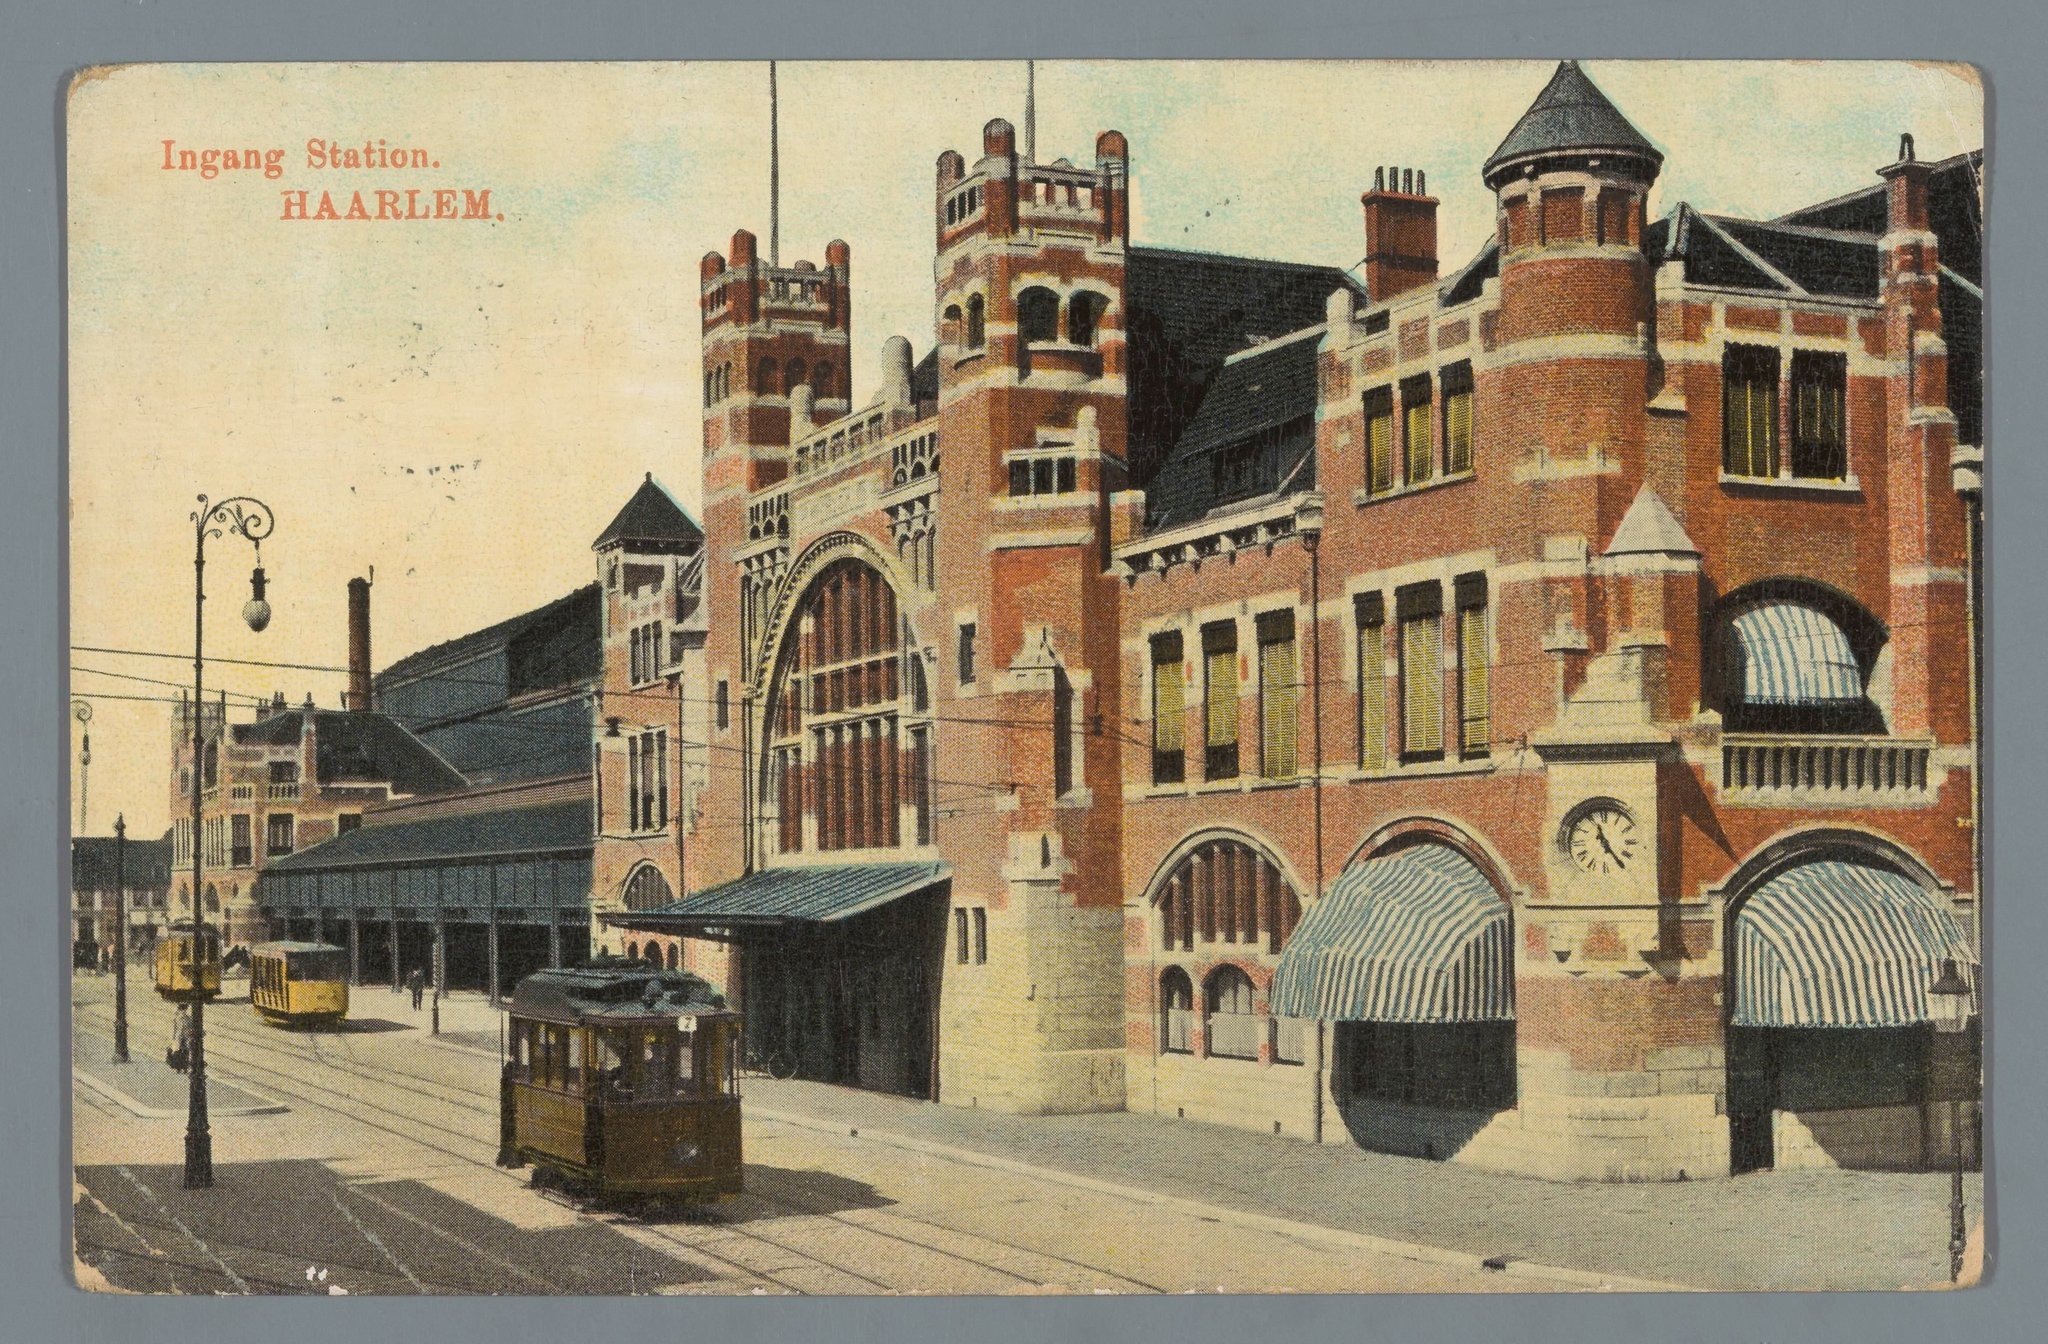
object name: photomechanical print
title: Ingang Station, Haarlem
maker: Anonymous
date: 1913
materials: cardboard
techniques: writing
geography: haarlem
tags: tram, station; shelter (railway, tramway)